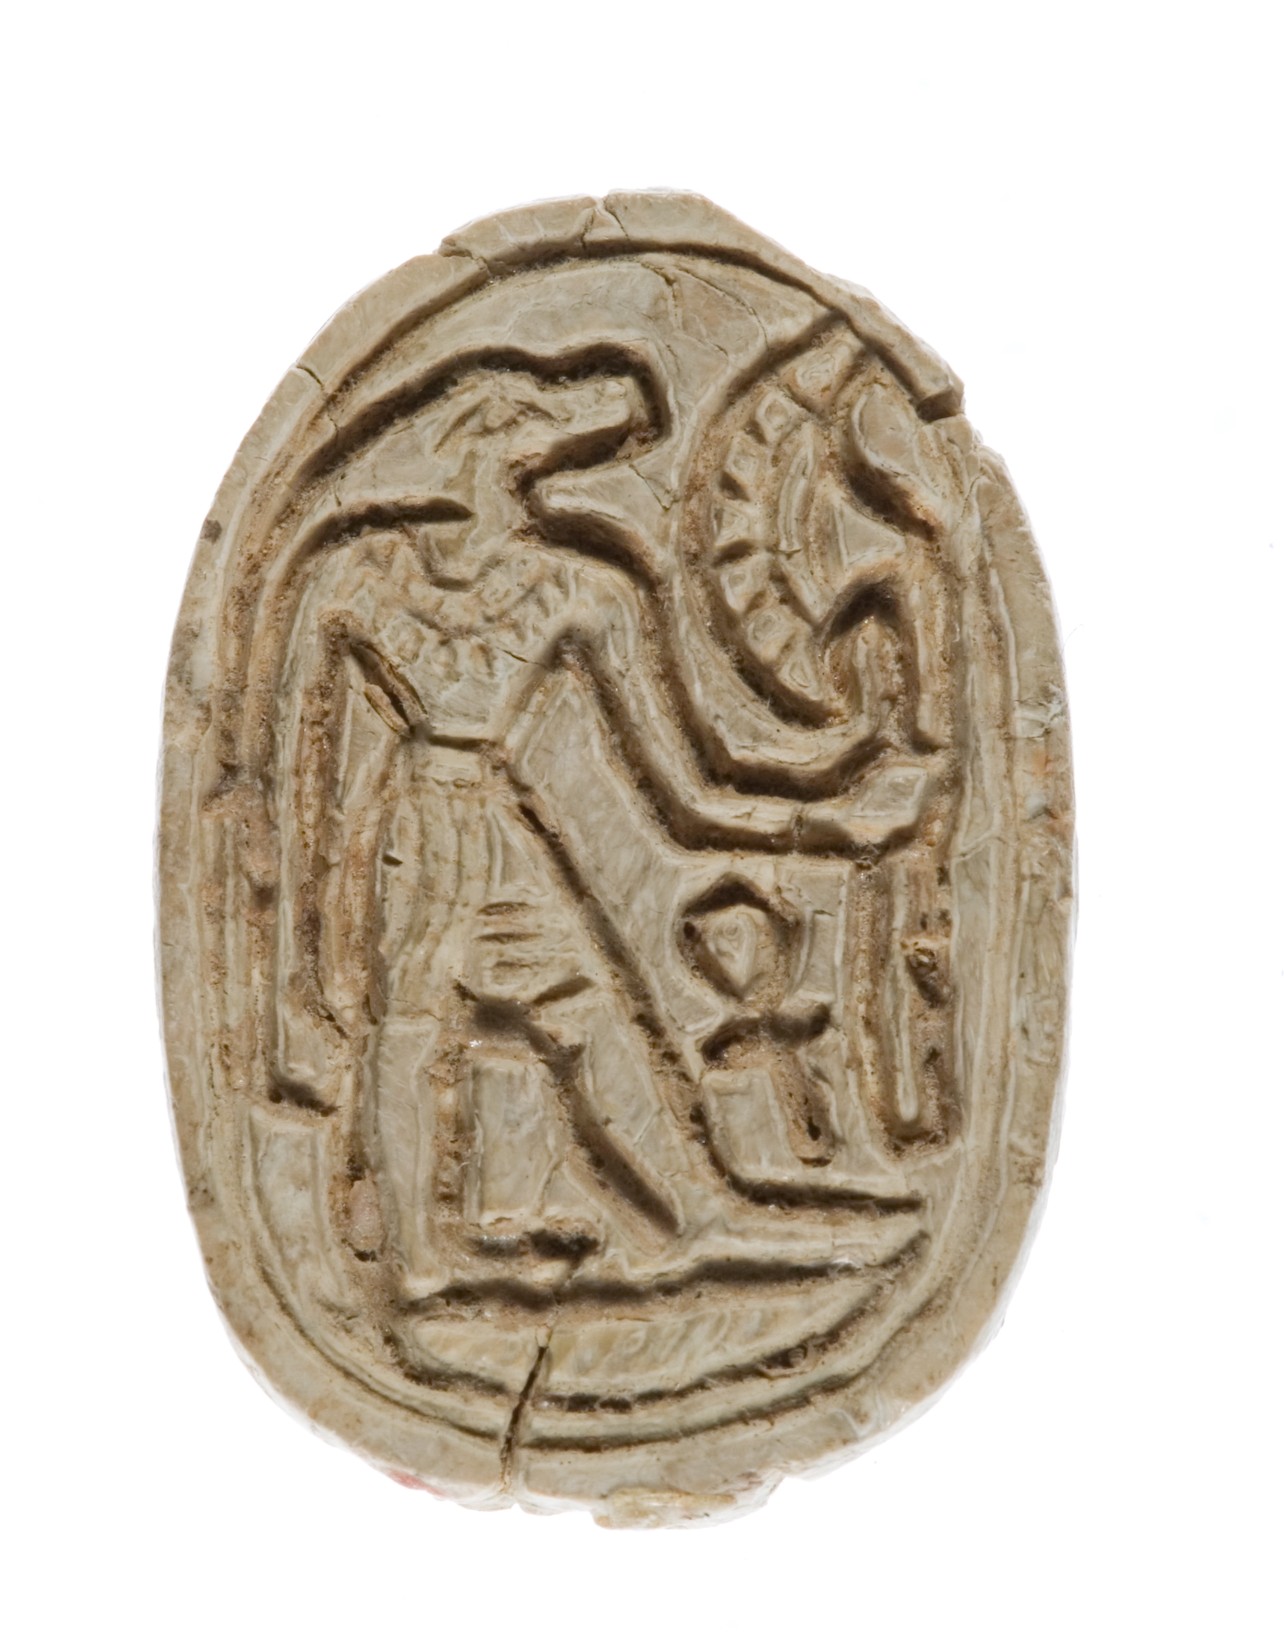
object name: scarab, crocodile figure, flower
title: Scarab with a Crocodile Headed Figure Holding a Flower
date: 1640-1550 BCE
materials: stone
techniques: glazing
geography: canaan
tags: scarabs